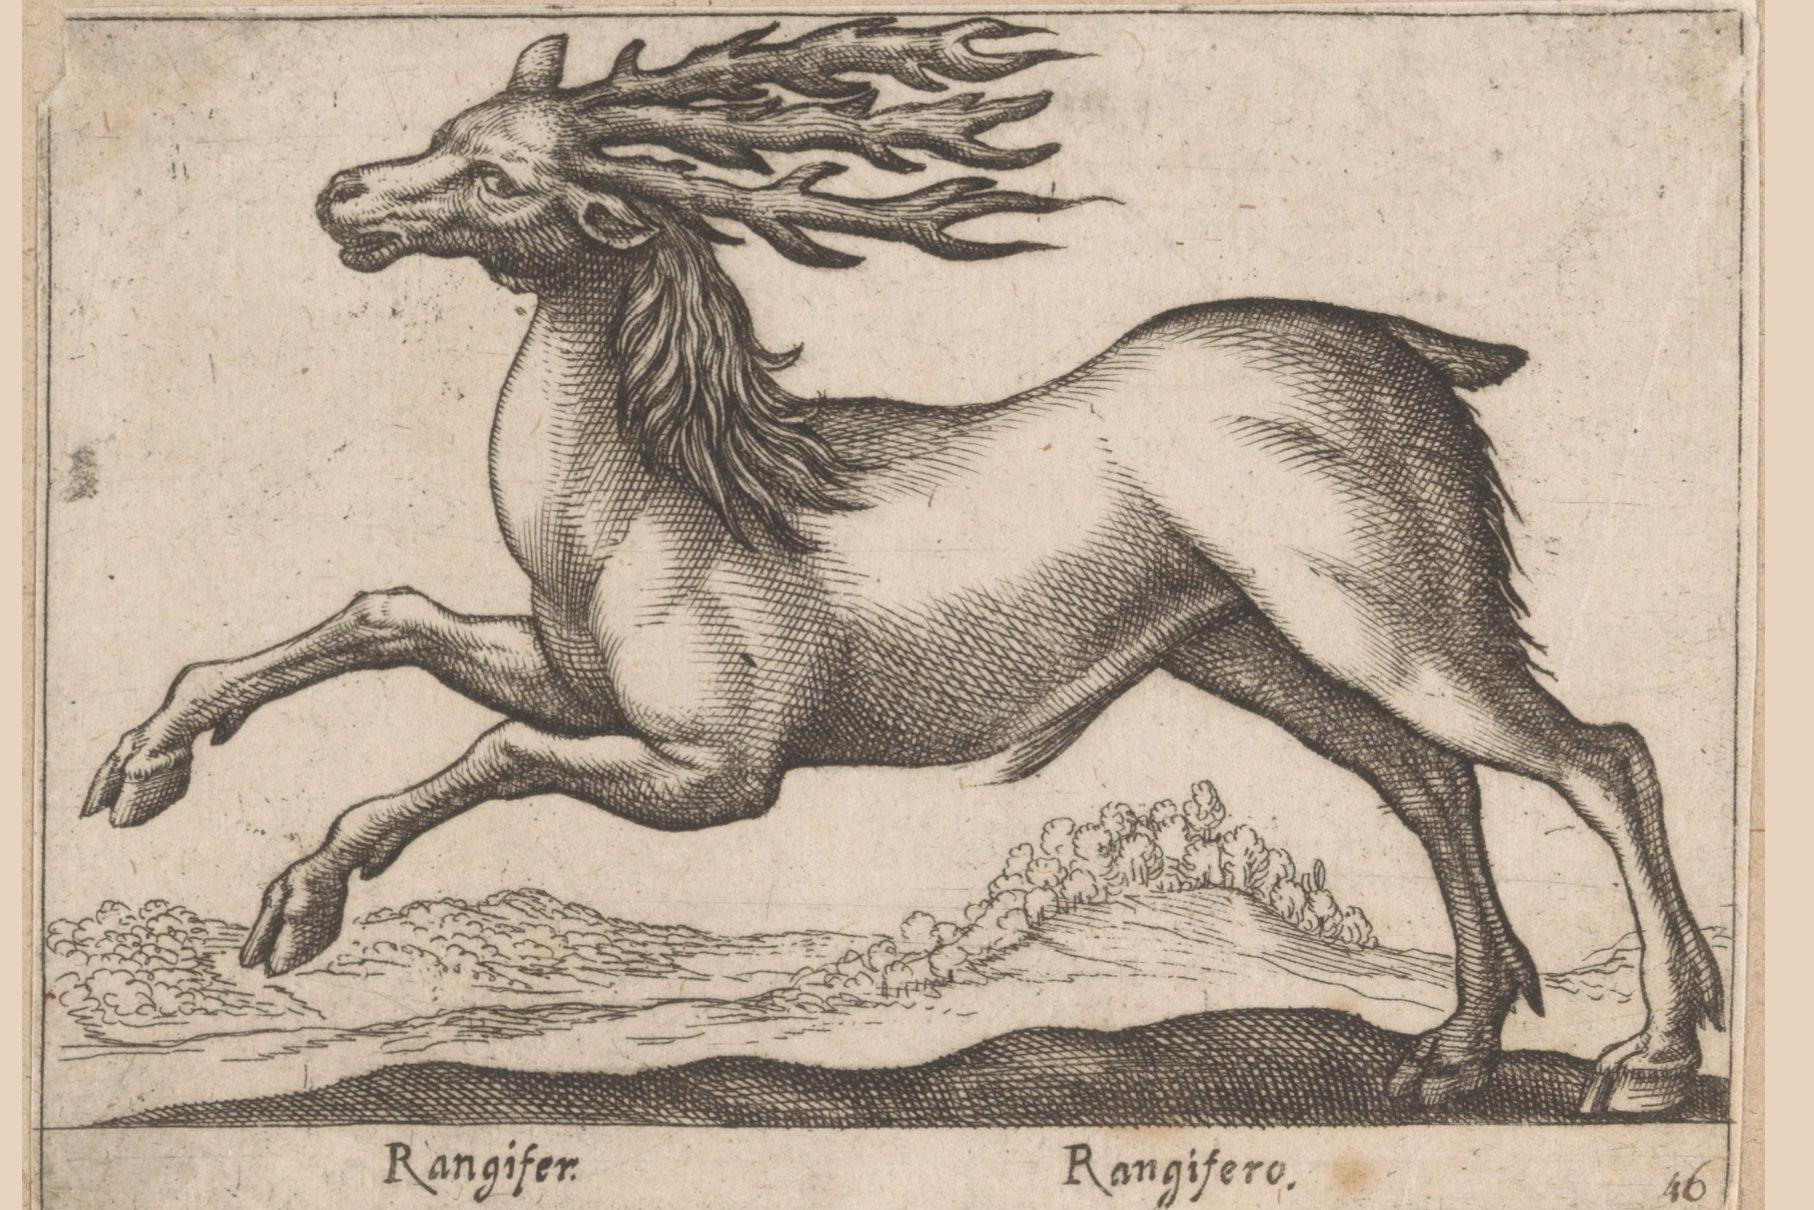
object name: print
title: Hert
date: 1565-1630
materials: paper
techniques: etching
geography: italy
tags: hoofed animals: deer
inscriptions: collector's mark: Lugt 11, number: ‘46’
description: Deze prent maakt deel uit van een reeks prenten van dieren door Antonio Tempesta. Bekend is dat een tweede staat (met nummering) van deze serie is uitgegeven door Giovanni Giacomo de' Rossi in 1650. Onbekend is wie de eerste staat heeft uitgegeven en wanneer.